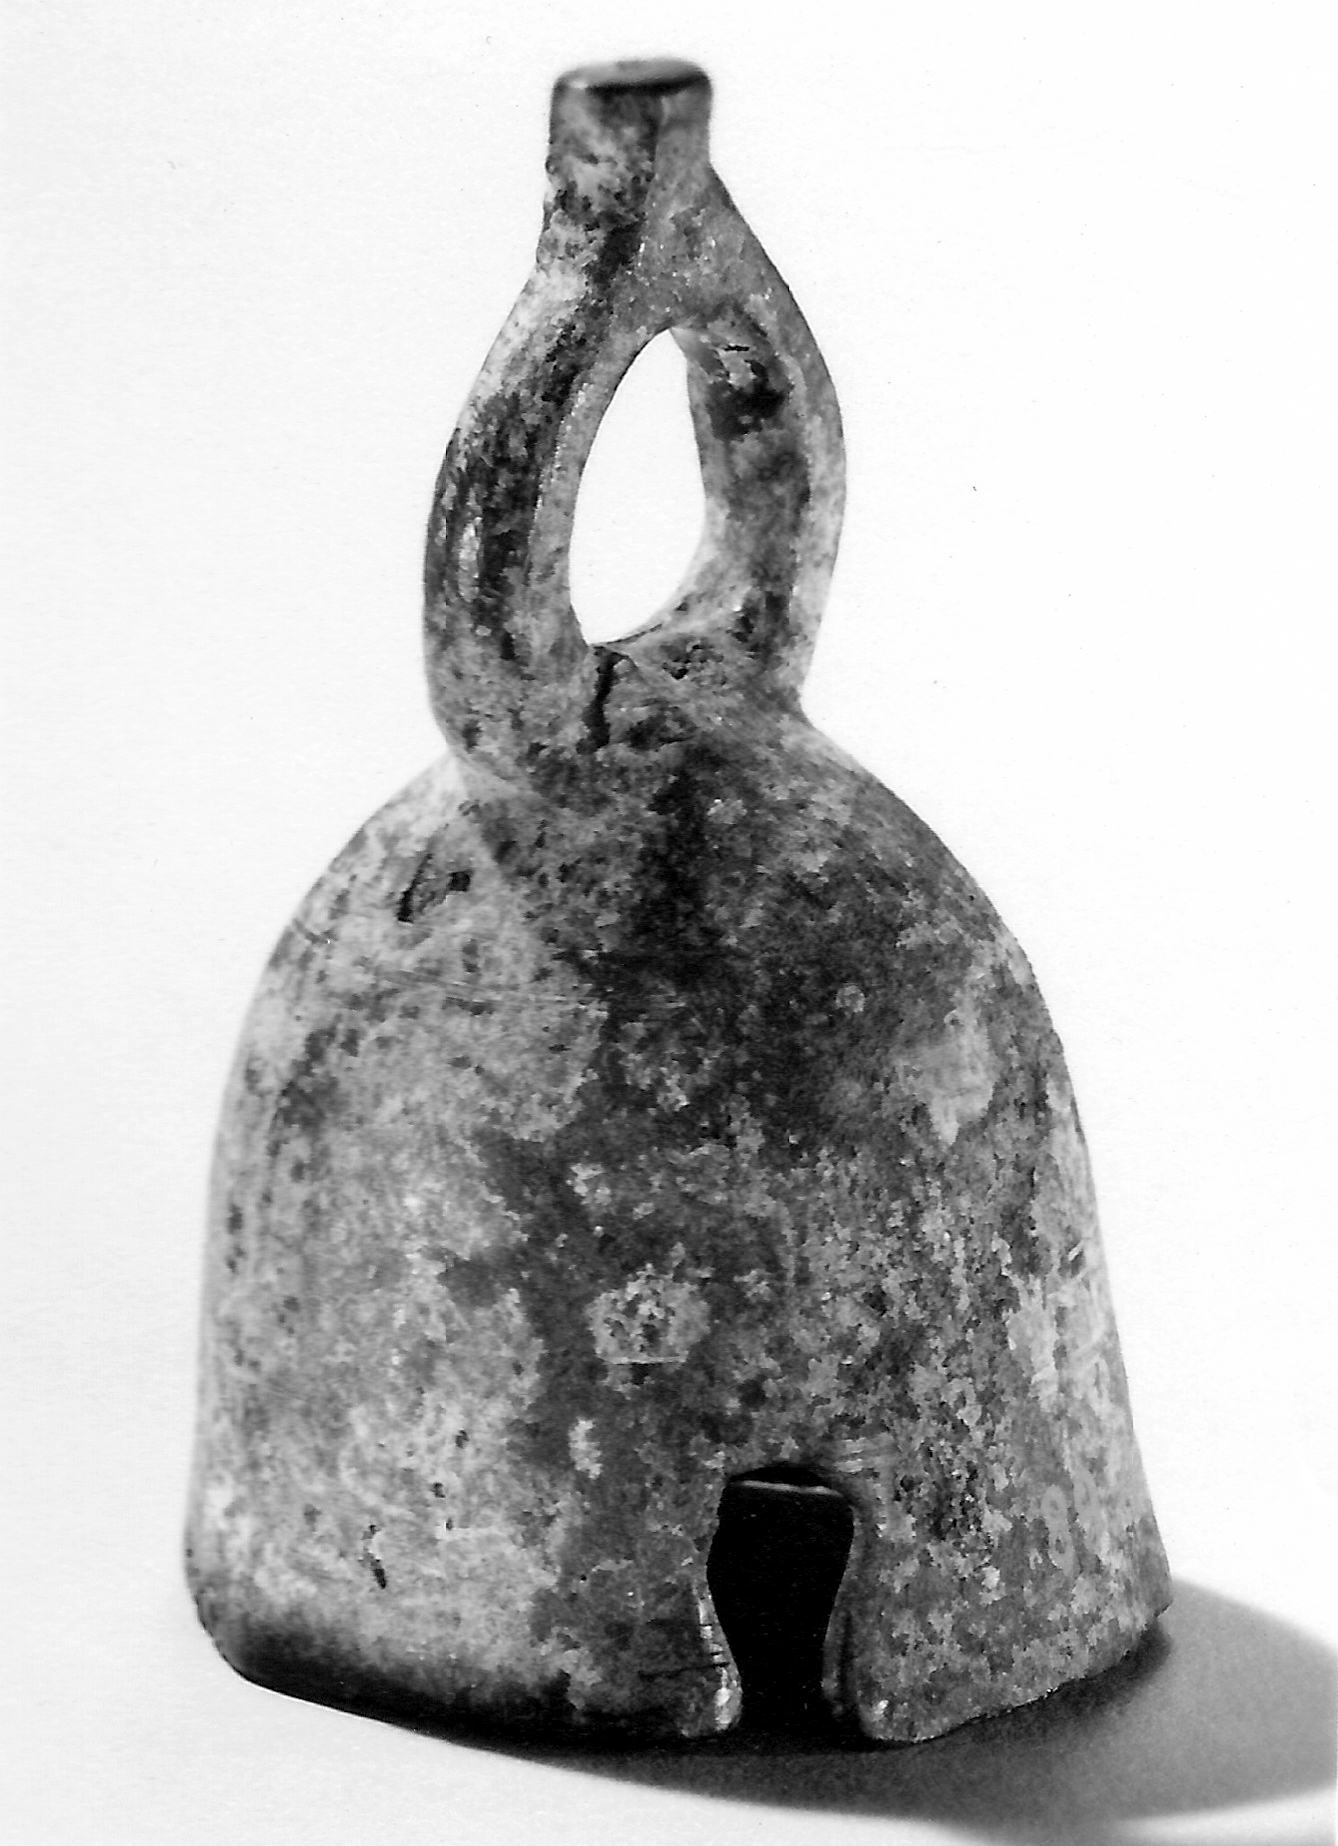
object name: bell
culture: roman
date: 1-100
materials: metal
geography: italy